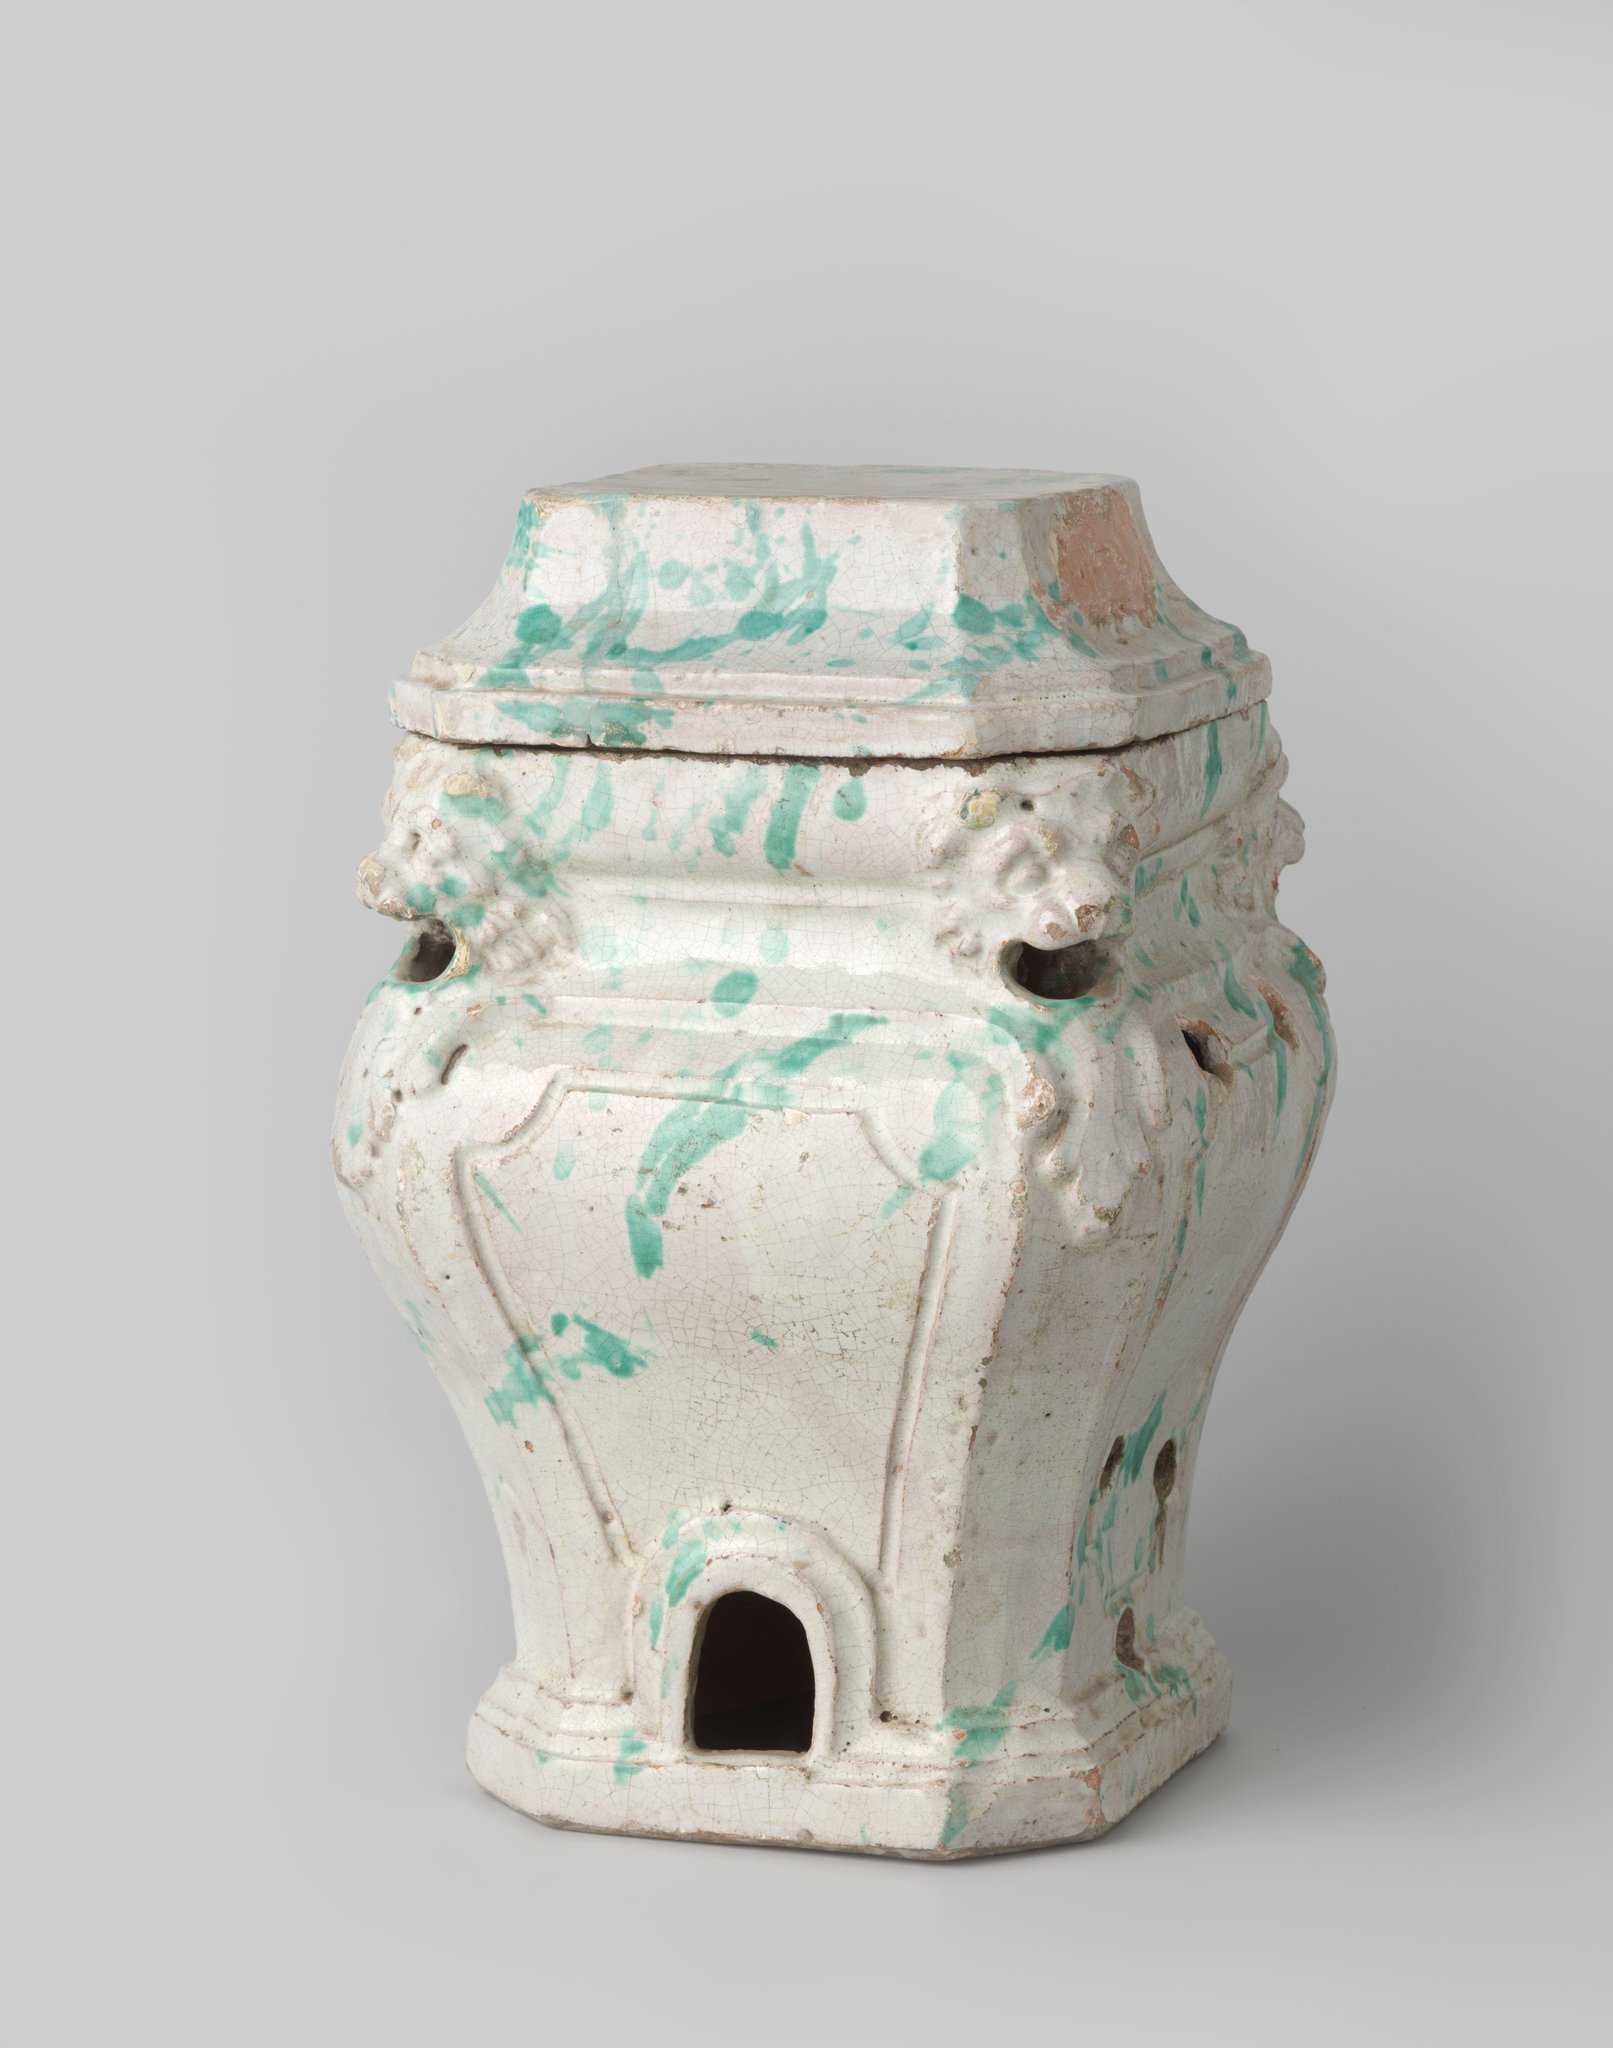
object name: vase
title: Vaas met deksel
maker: Anonymous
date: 1700-1800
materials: ceramic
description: De vaas heeft een vierkante vorm met een 'bolle' buik. Wit onderglazuur met lichtgroene blader-achtige motieven. Op de hoeken van de vaas zitten leeuwekoppen met een open bek.